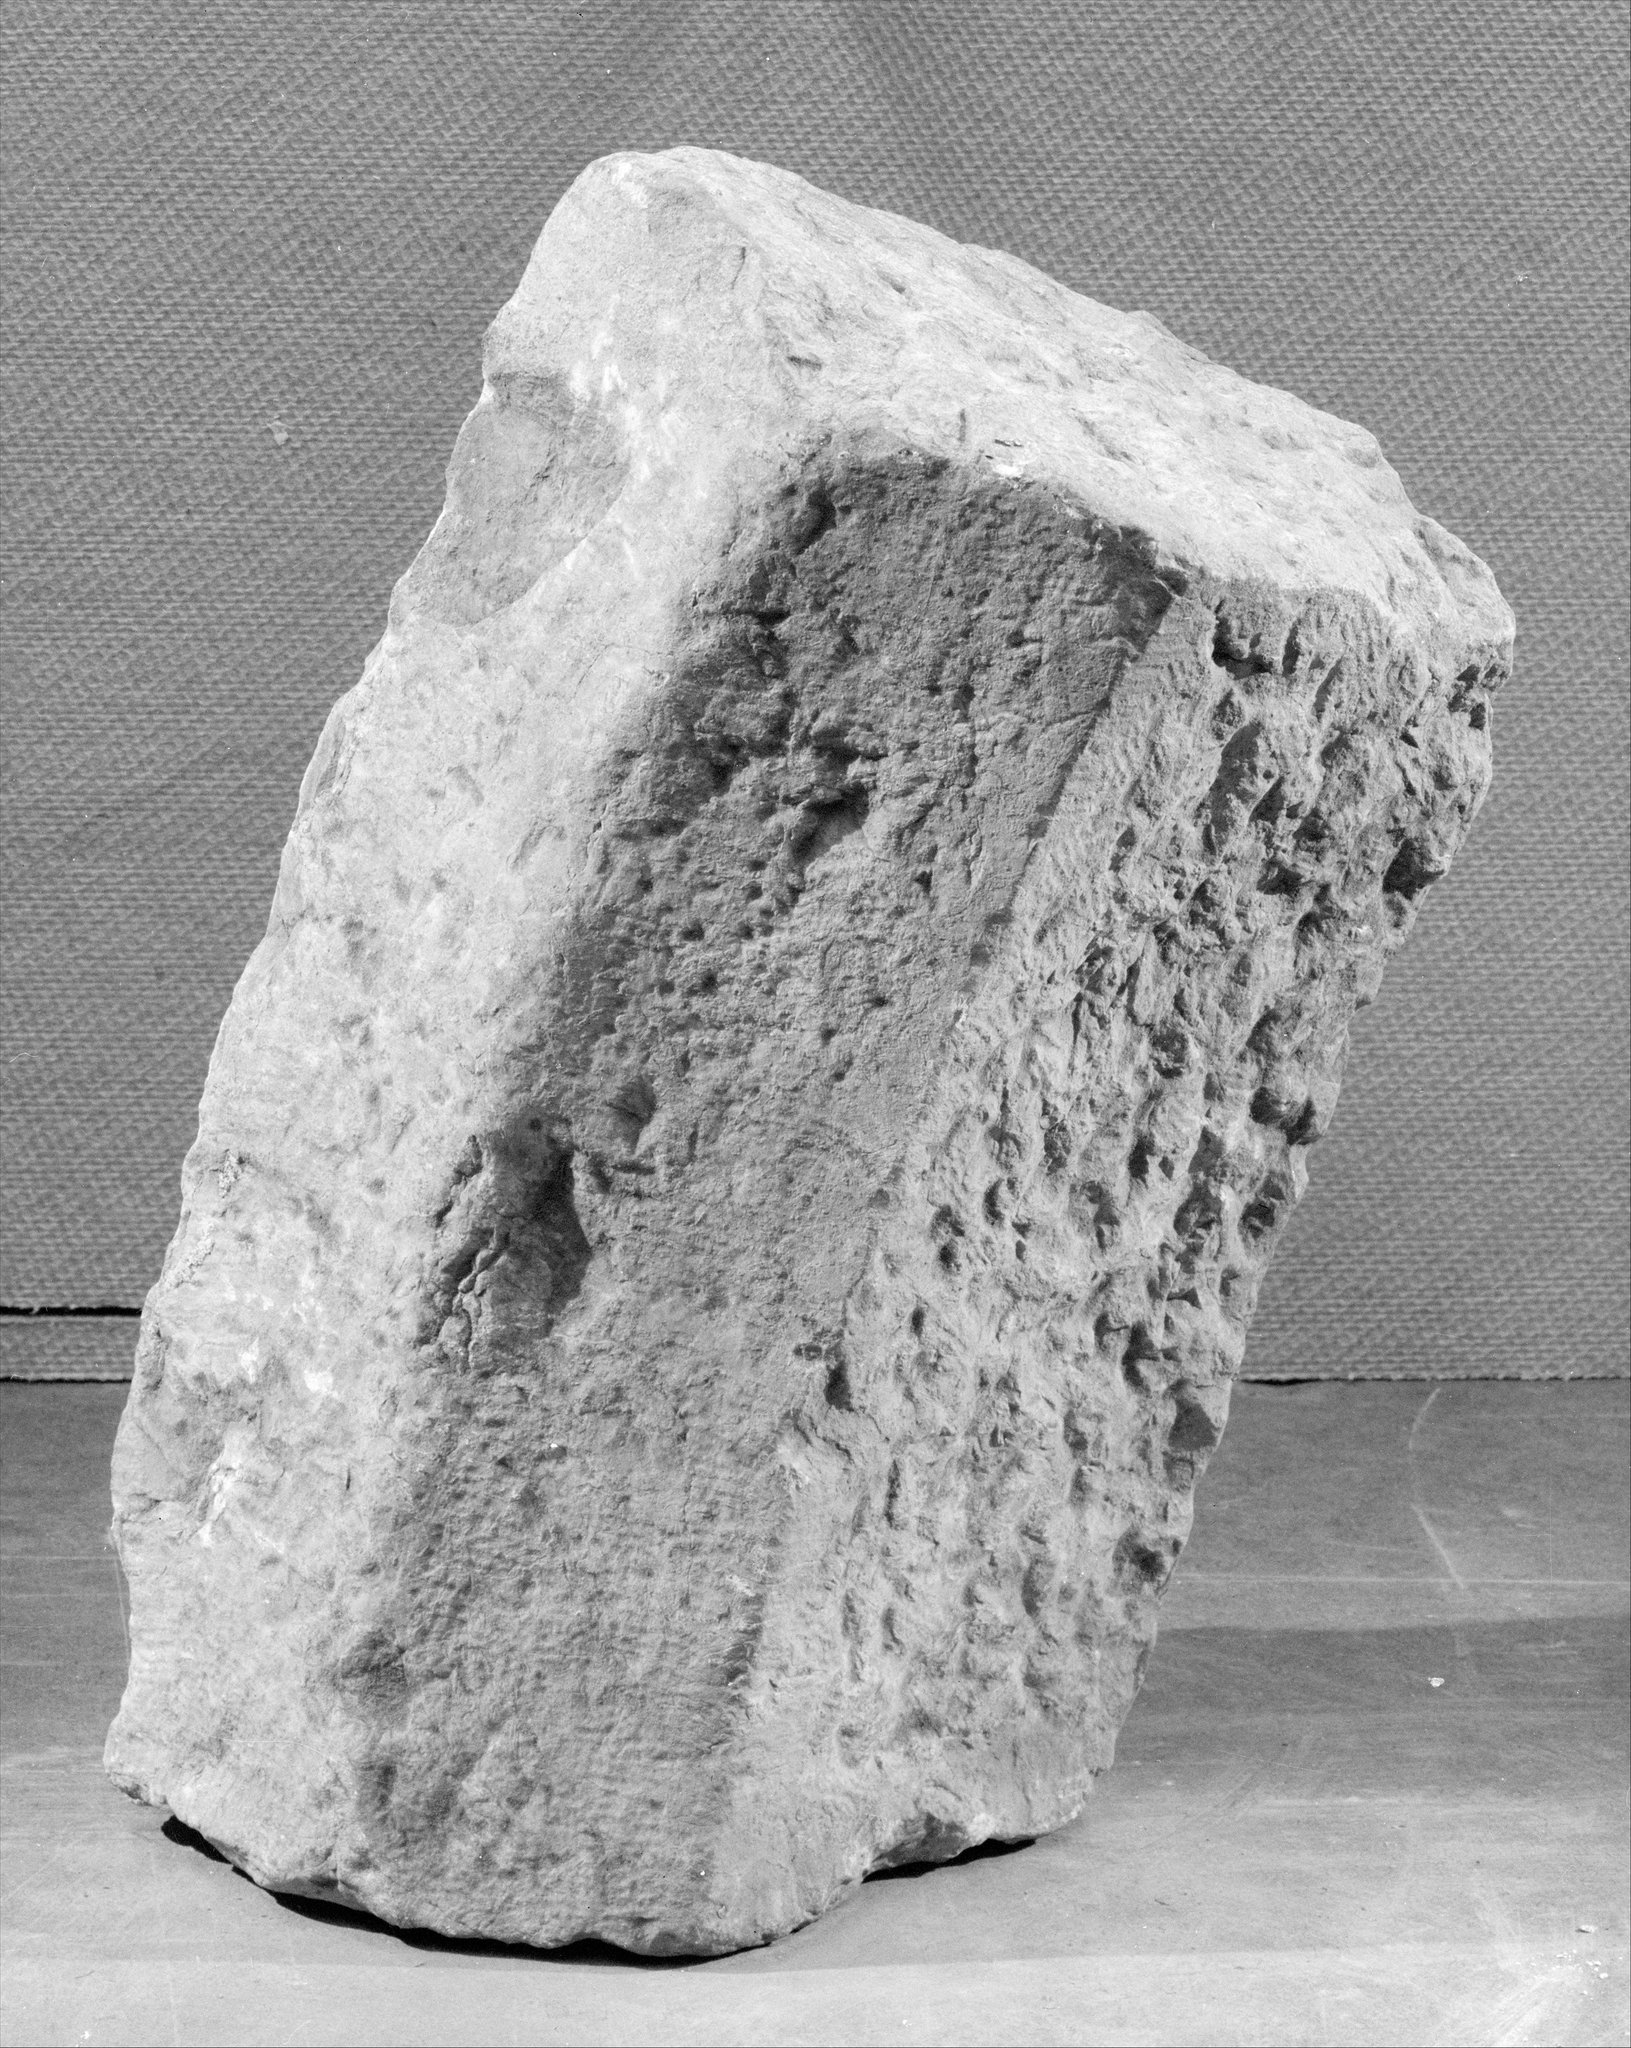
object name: block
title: Block Fragment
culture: french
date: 1130-1140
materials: stone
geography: france